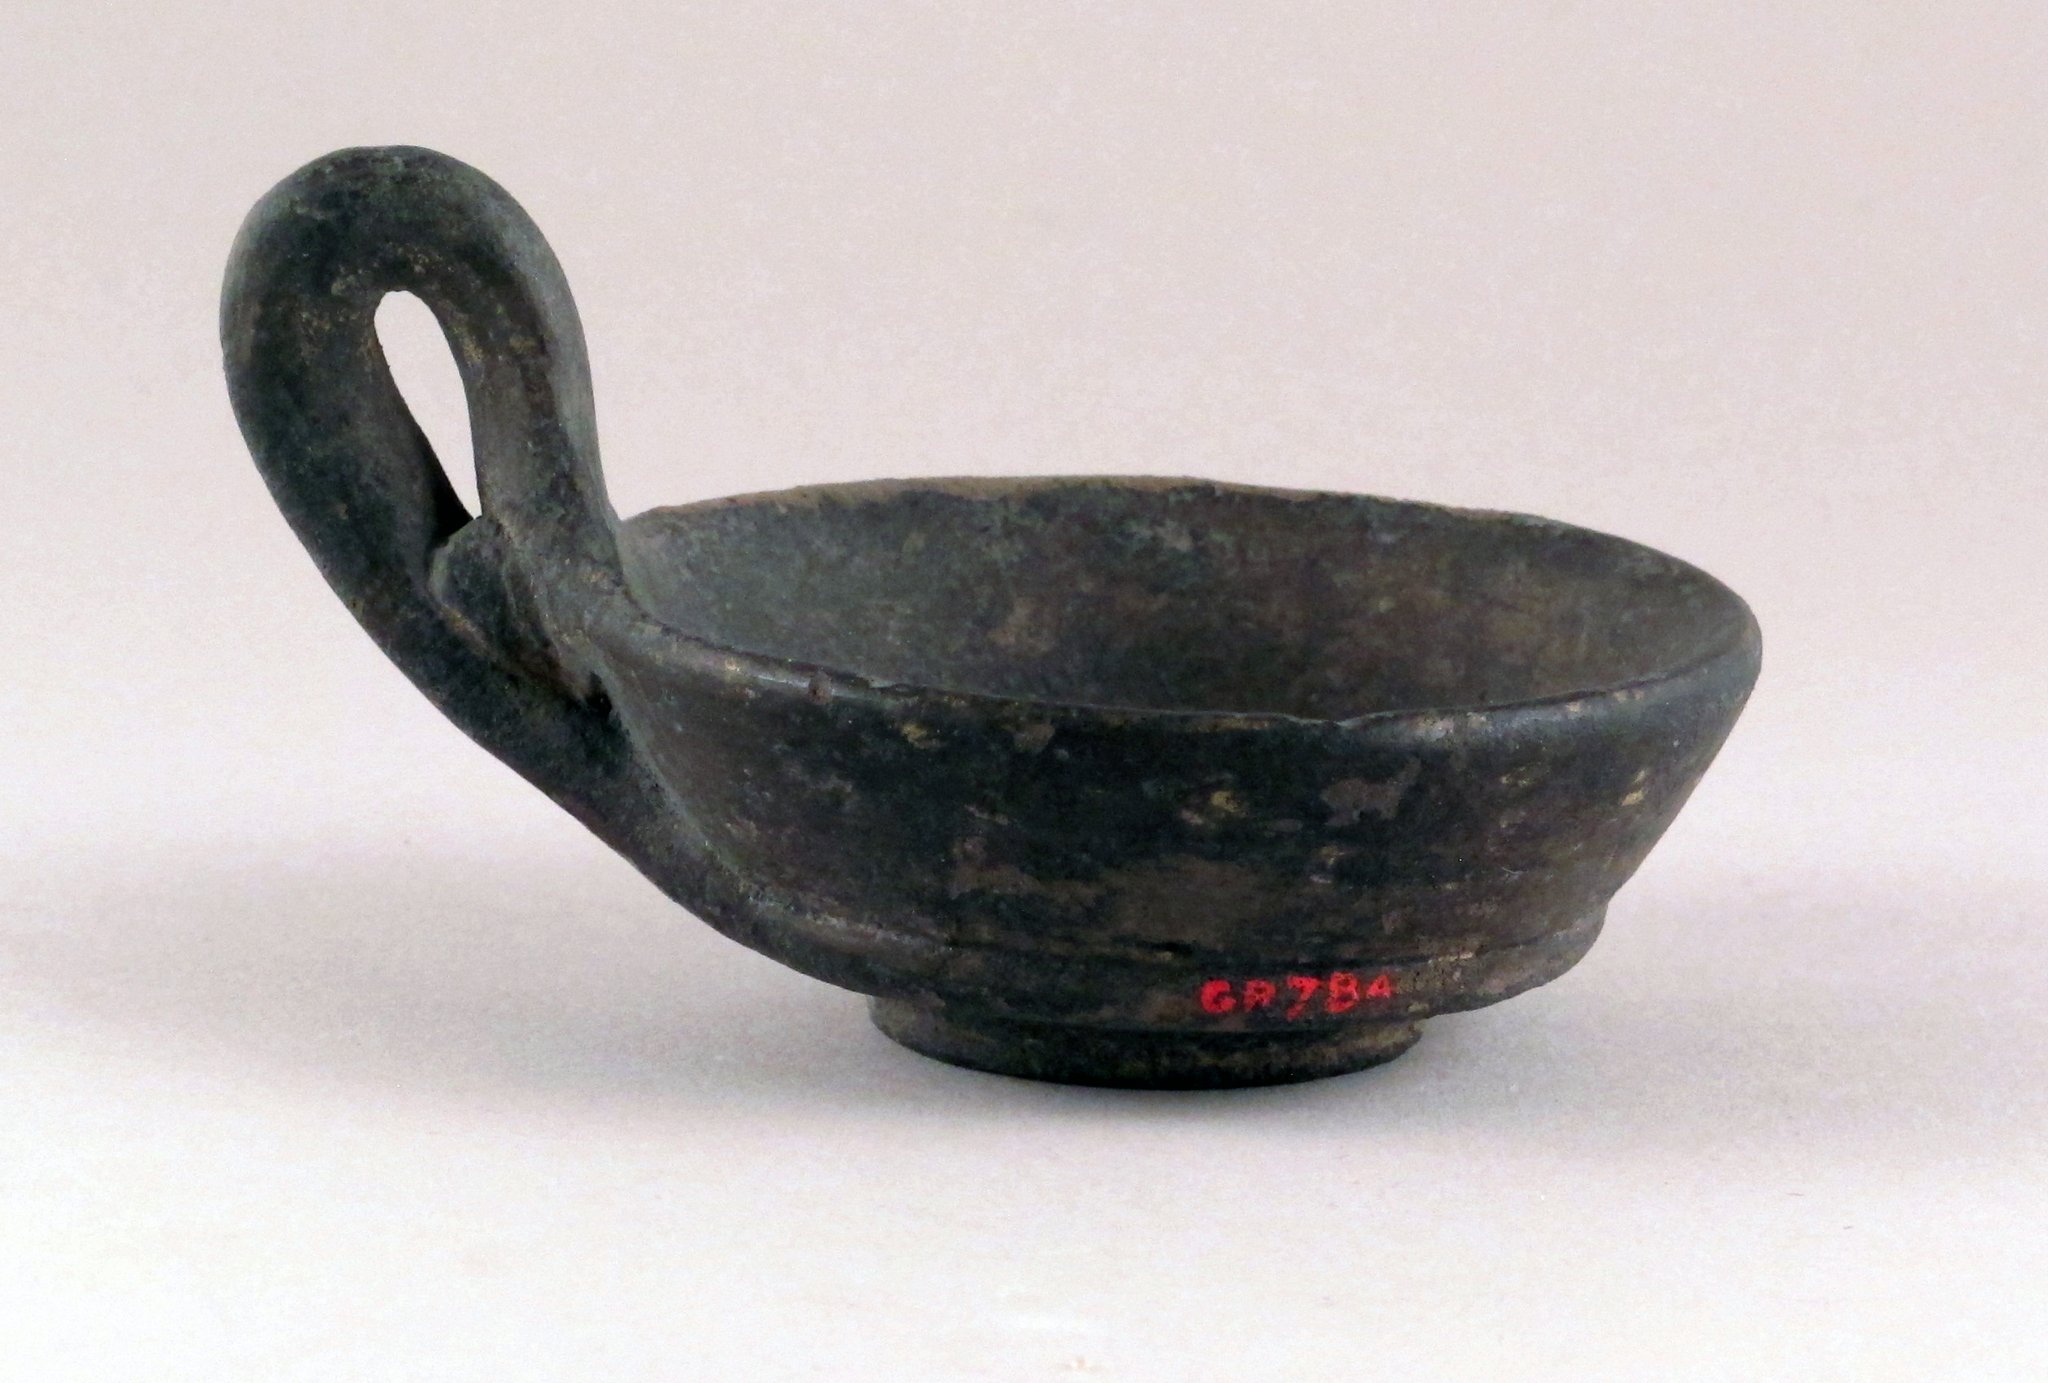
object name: cup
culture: etruscan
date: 600-501 BCE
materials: terracotta